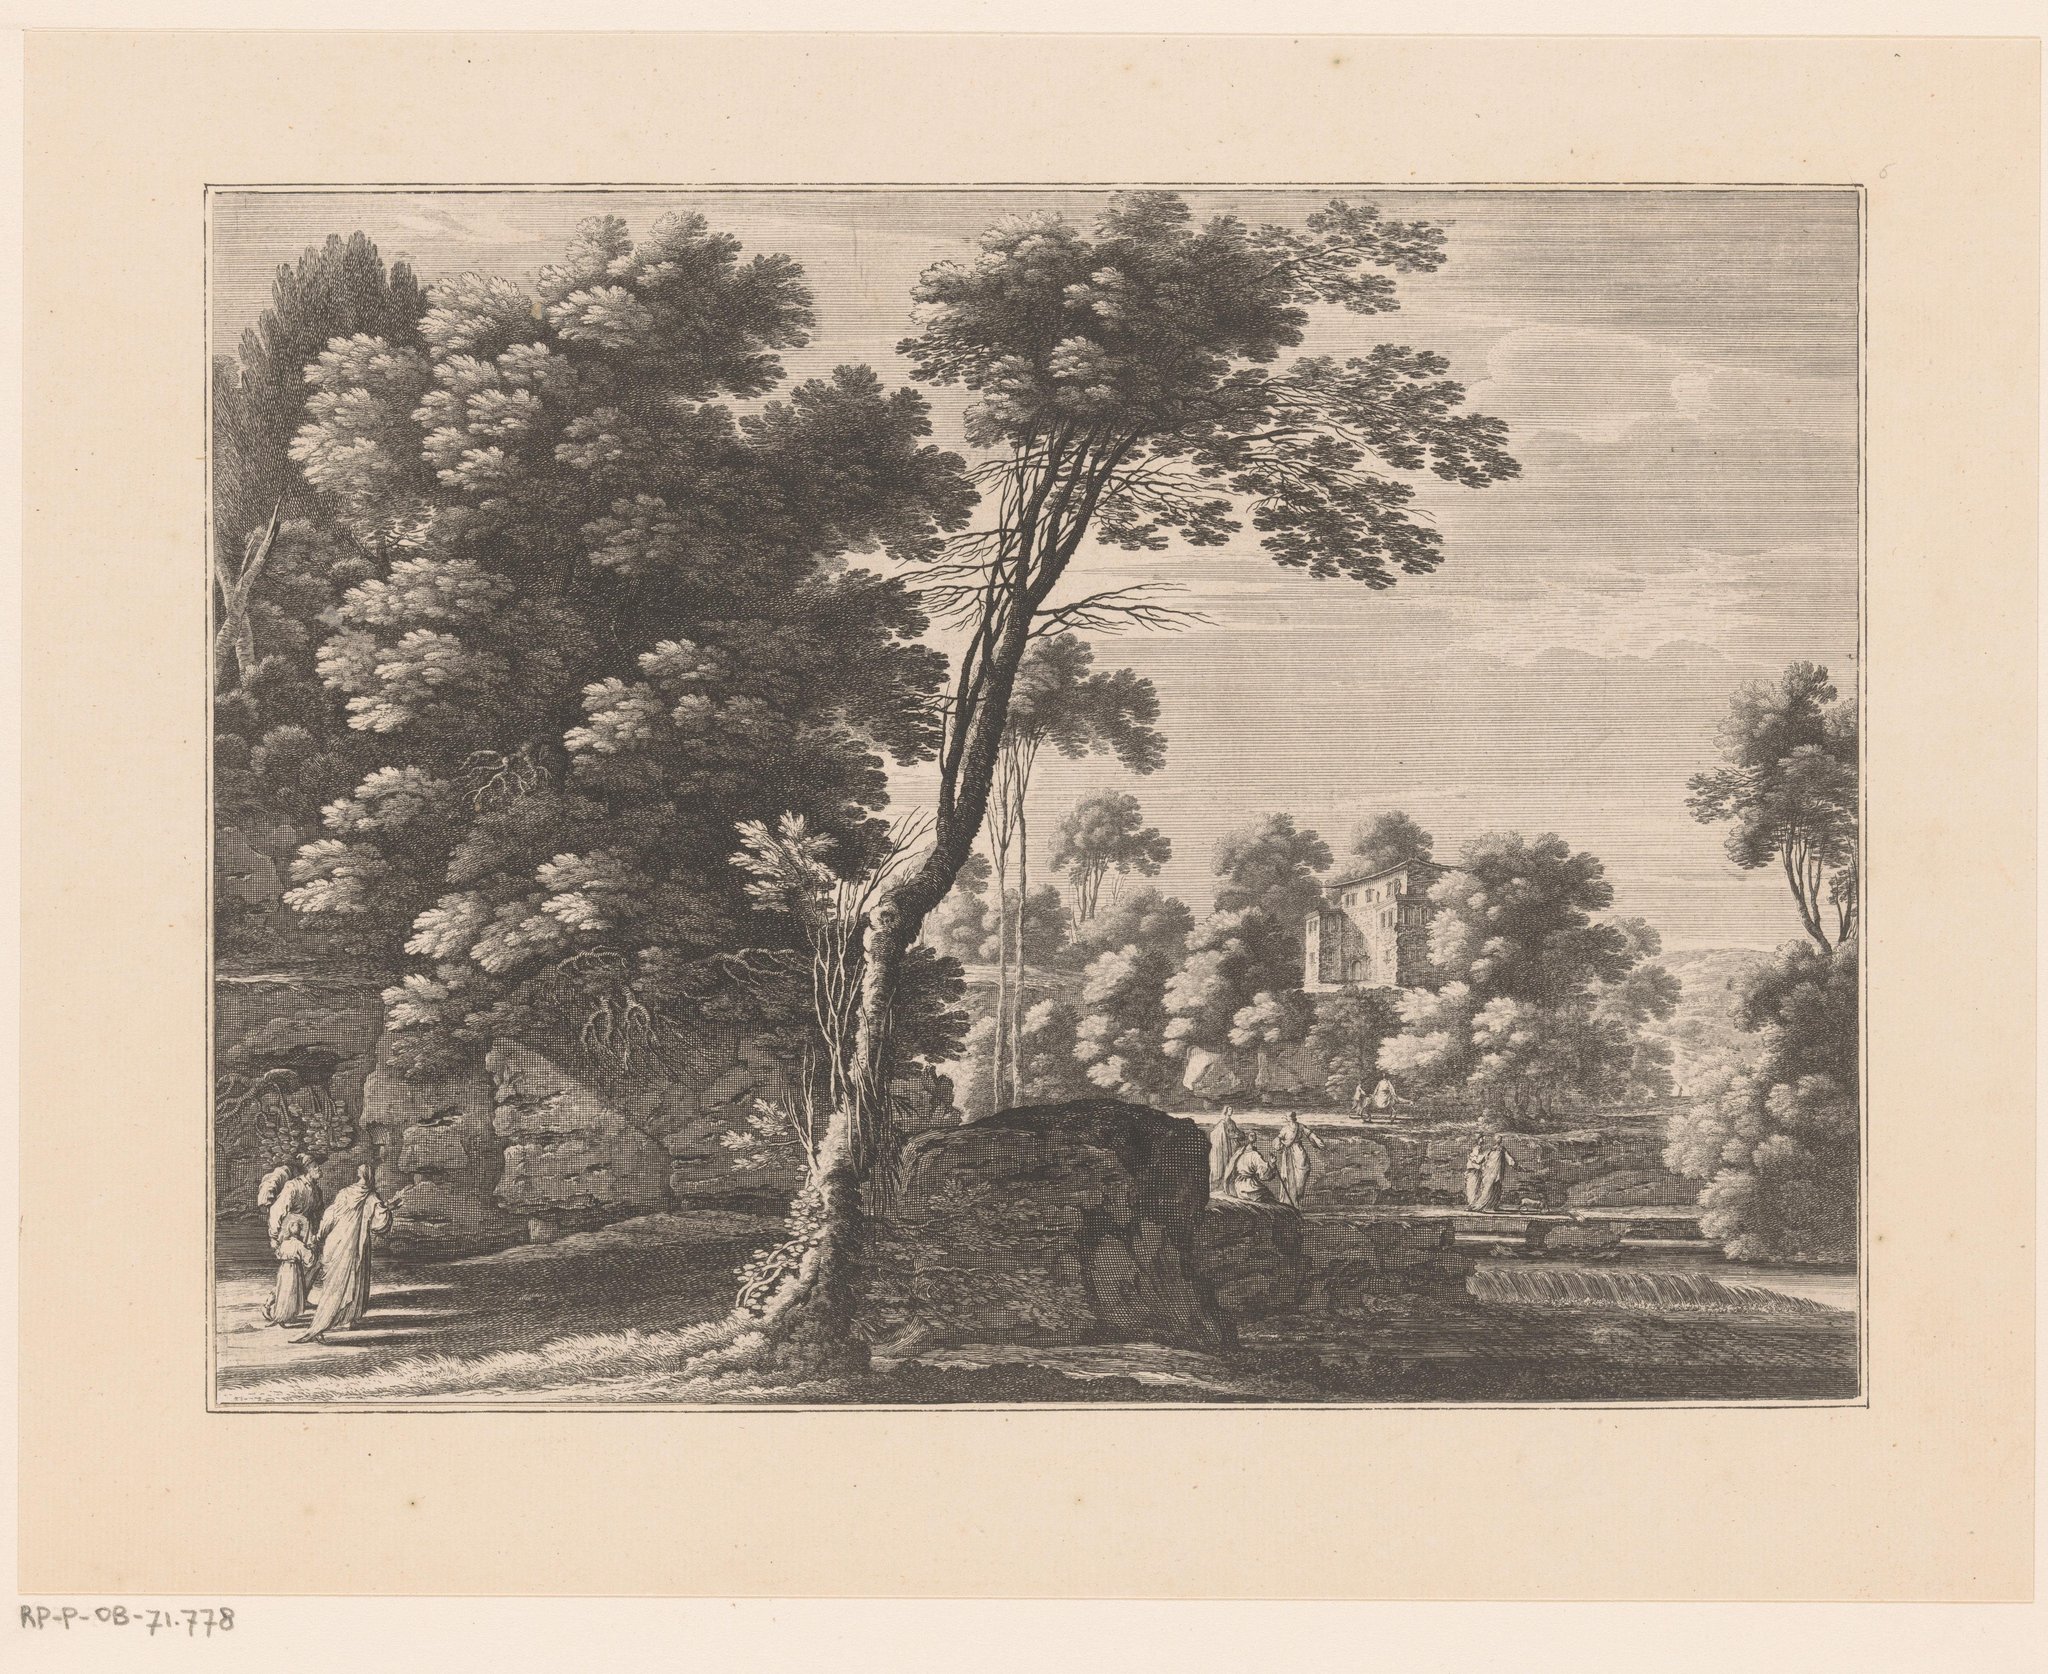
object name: print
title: Landschap met reizigers en Heilige Familie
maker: pierre drevet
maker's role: print maker, publisher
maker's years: 1663-1738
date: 1663-1695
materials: paper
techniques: etching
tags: landscapes, holy family, and derived representations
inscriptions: collector's mark: Lugt 240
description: Prenten met het signatuur 'Perelle' kunnen zowel door vader Gabriel als door zonen Nicolas en Adam gemaakt zijn.